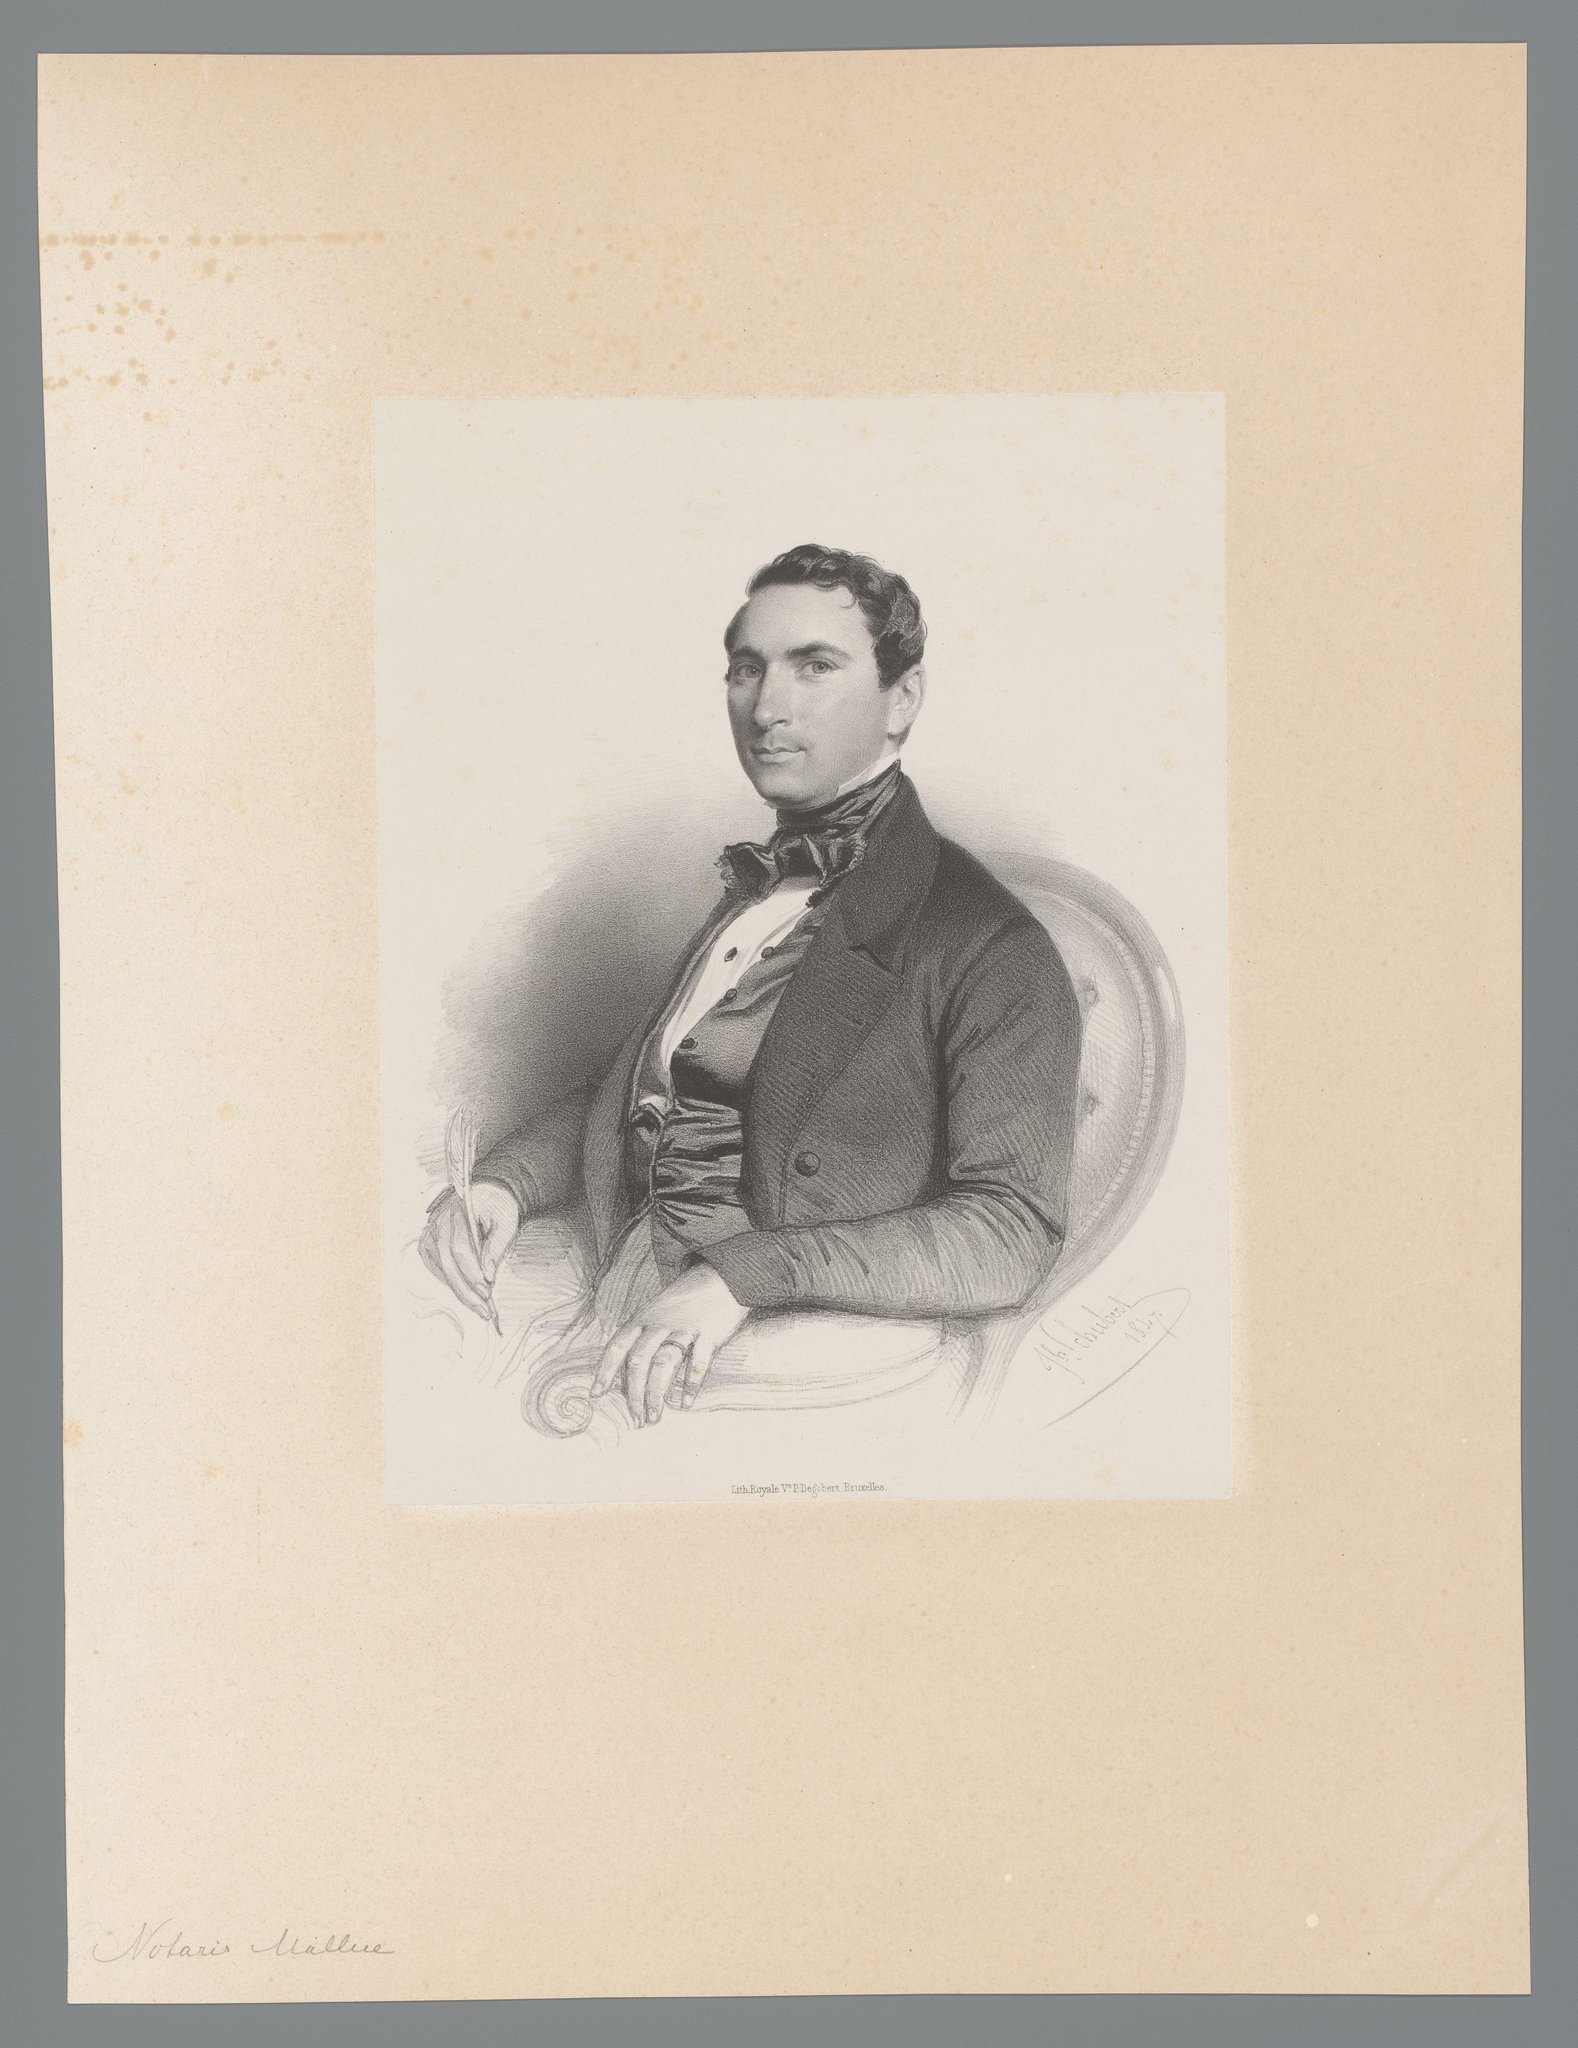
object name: print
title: Portret van notaris Malluc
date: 1847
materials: paper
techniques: lithograph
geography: brussels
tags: historical persons, notary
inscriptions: collector's mark: Lugt 2228